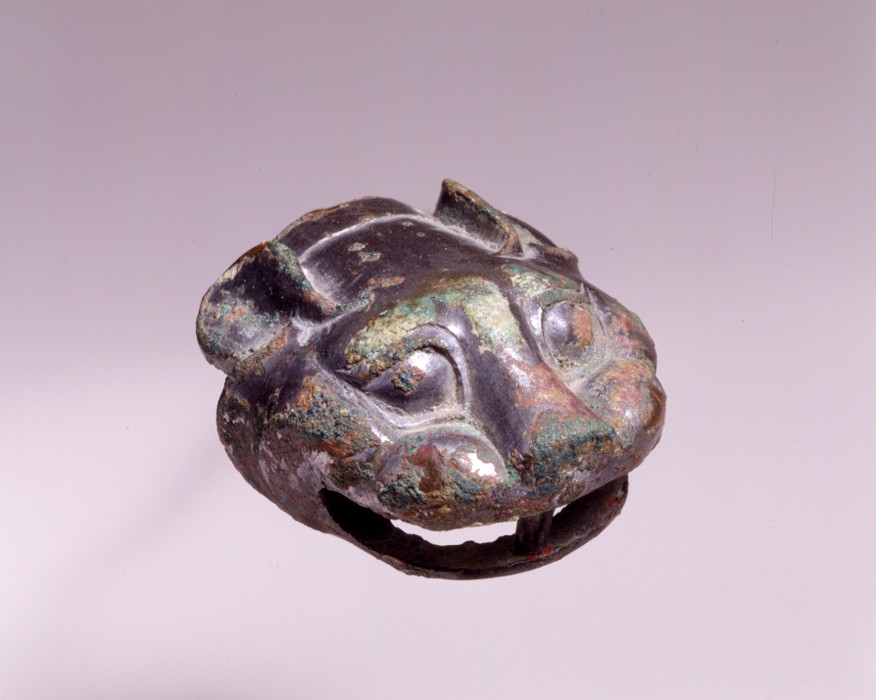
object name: finial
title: Finial in the Shape of a Tiger's Head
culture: chinese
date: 300-201 BCE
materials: bronze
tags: tigers